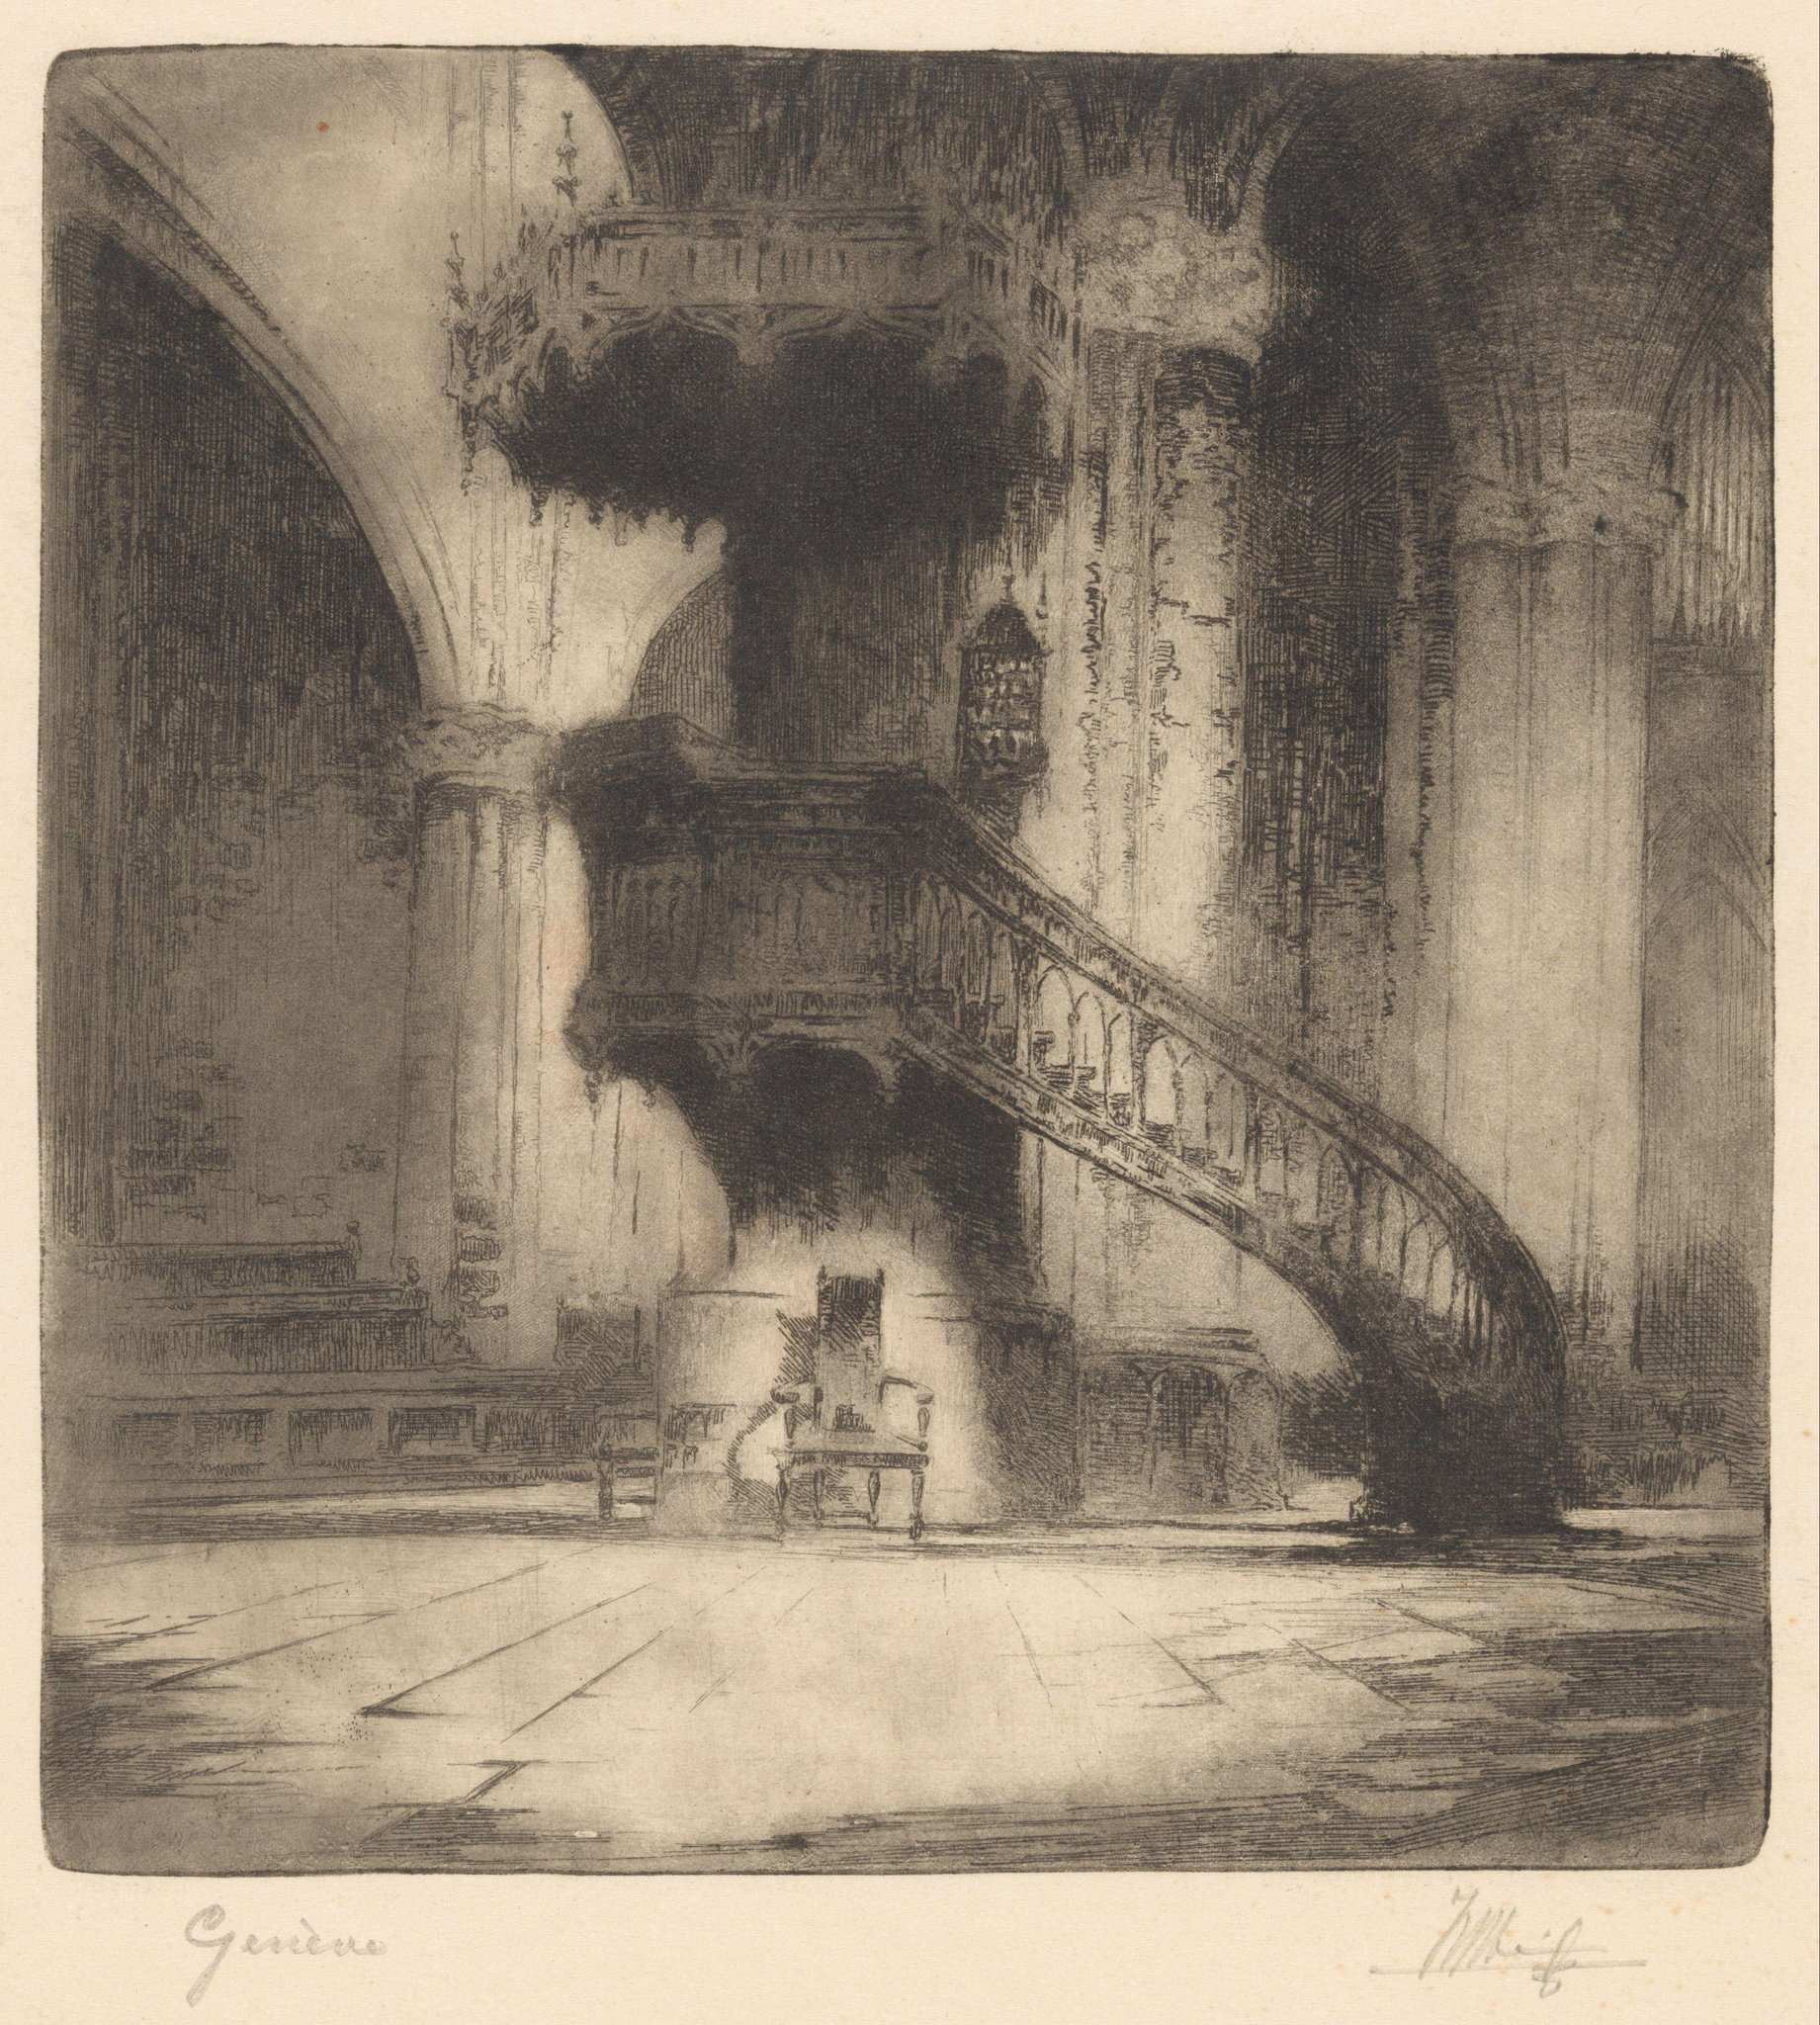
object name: print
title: Kerkinterieur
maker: kornelis jacobus huineman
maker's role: draughtsman, print maker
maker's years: 1886-1952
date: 1901-1952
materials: paper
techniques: etching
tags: interior of church, pulpit, ambo, chancel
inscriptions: collector's mark: Lugt 2228